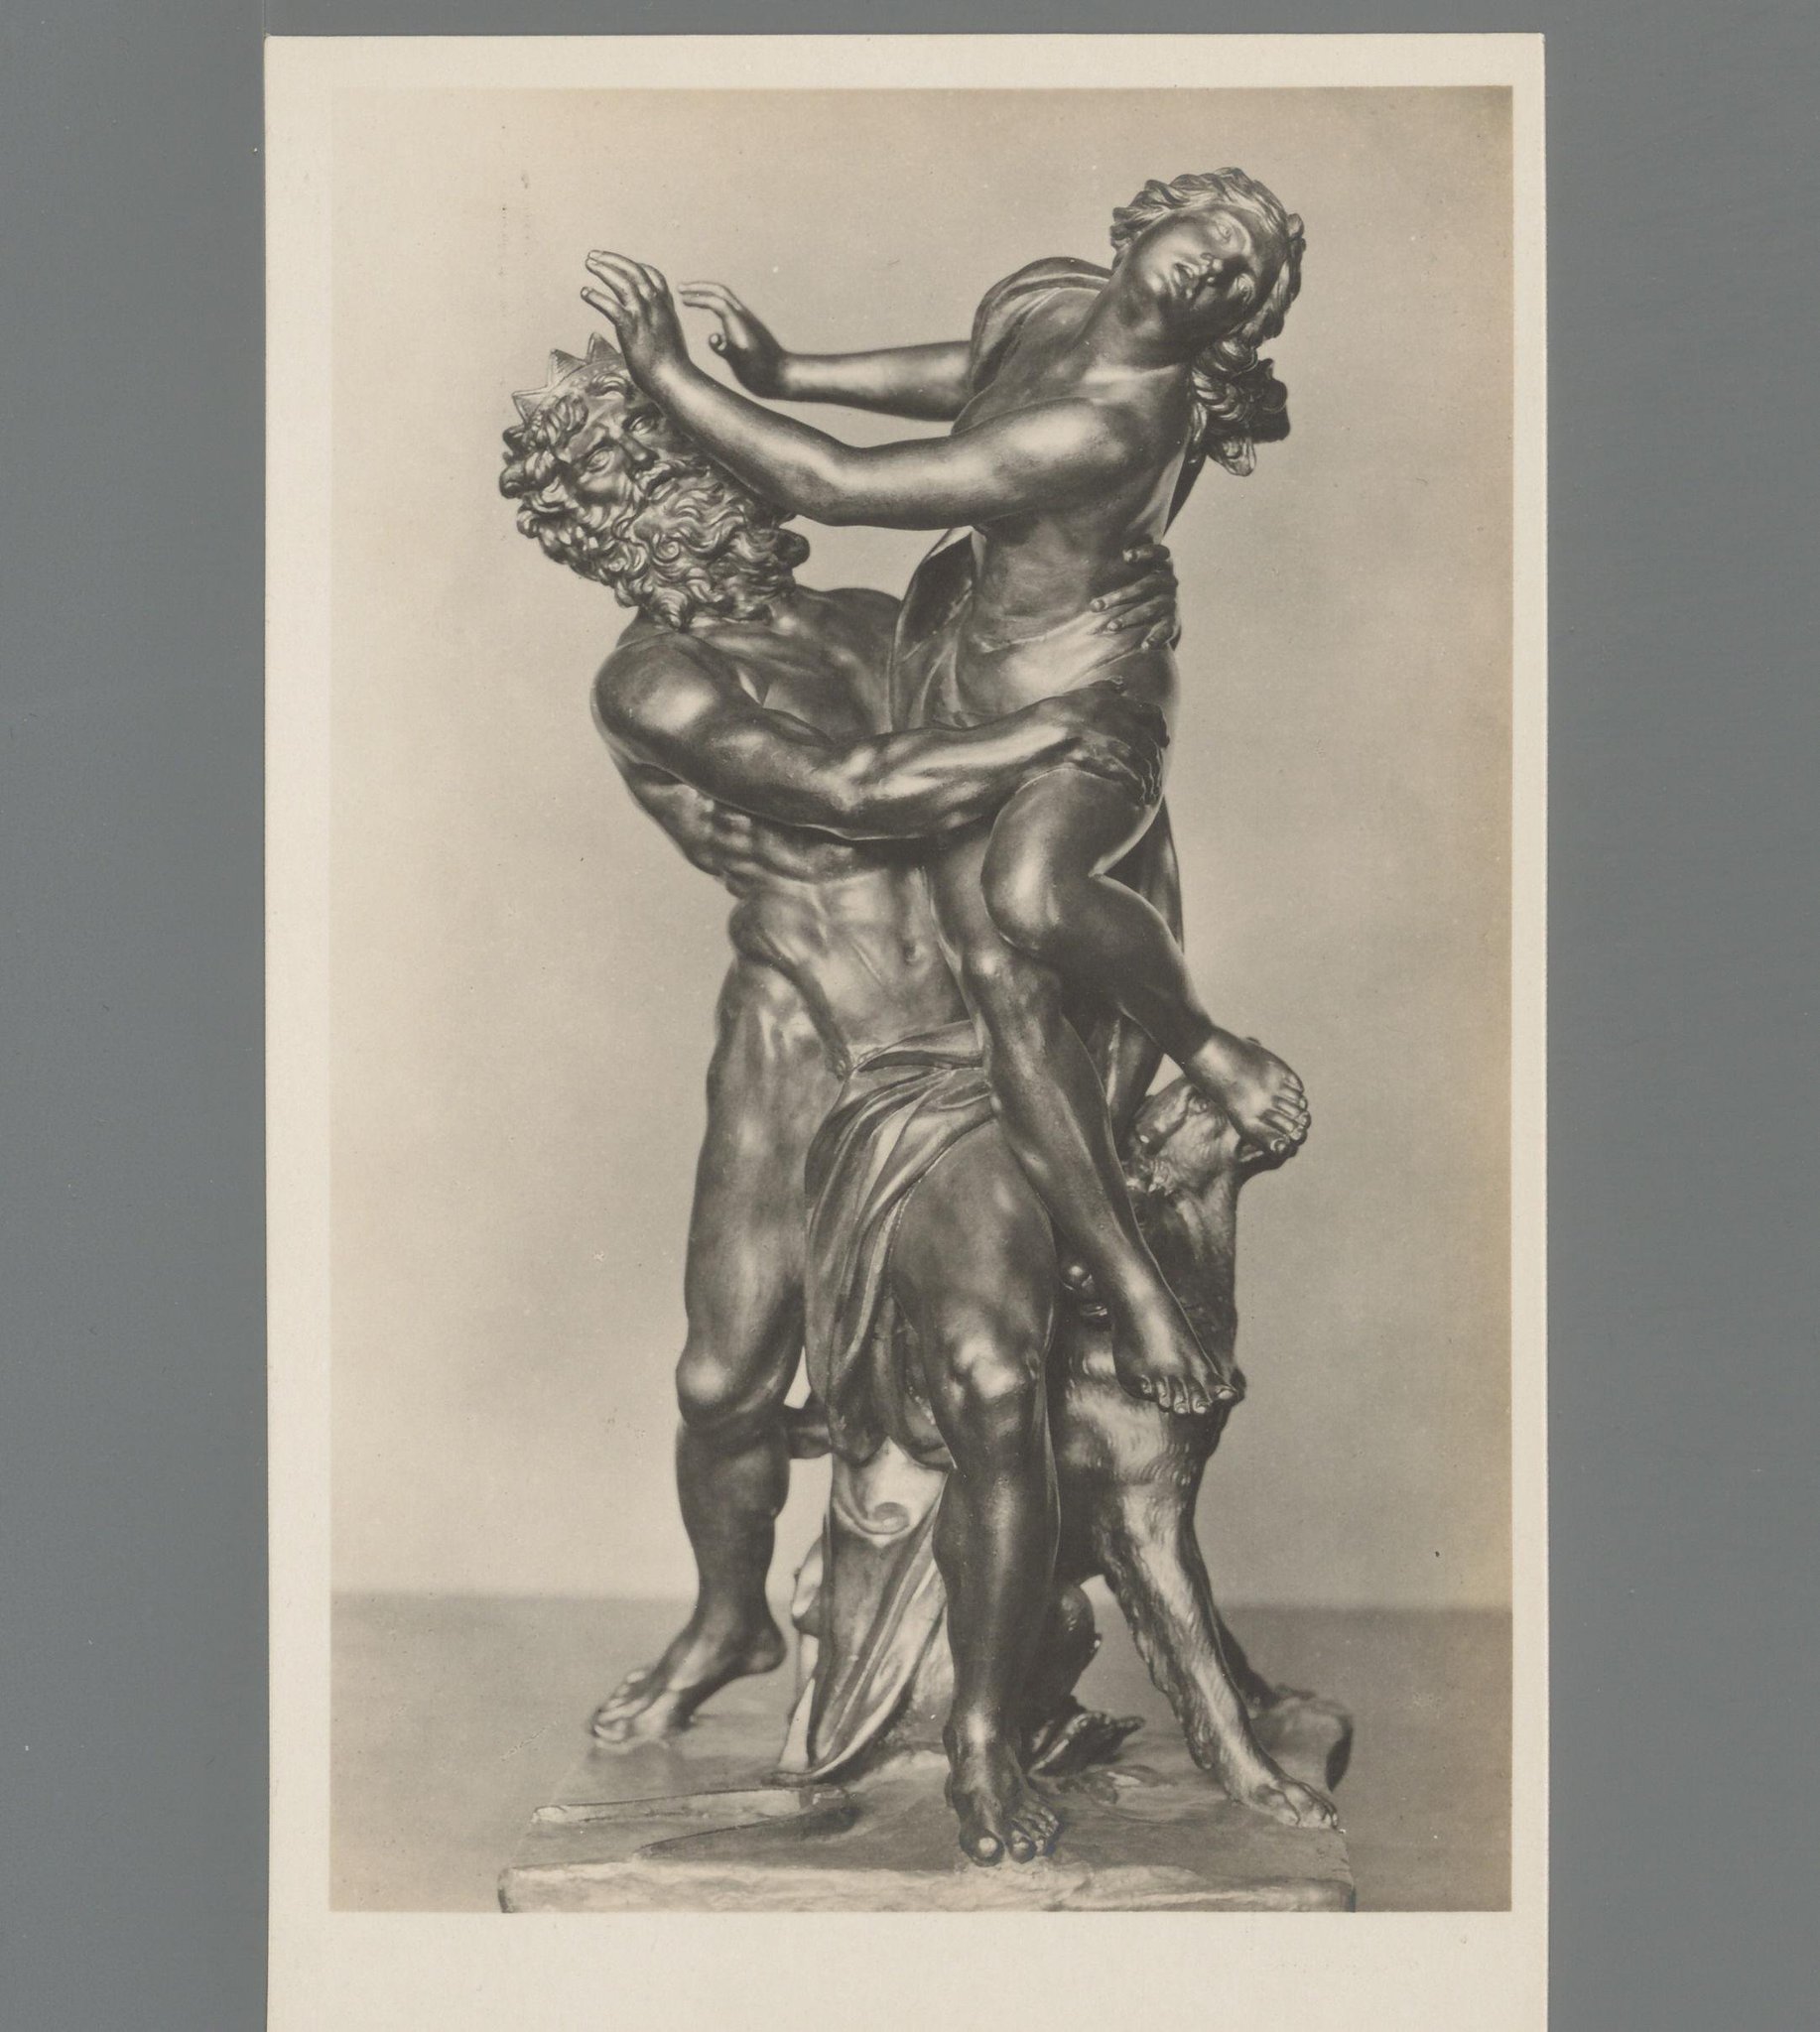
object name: ansichtkaart, prentbriefkaart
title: Berlin, Schlossmuseum. Lorenzo Bernini (1598-1680). Raub der Proserpina, Bleiguss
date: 1918-1930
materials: photographic support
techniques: photography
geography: berlin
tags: castle, statues, paintings, etc. ~ objects of worship in roman religion, permanent exhibition, museum